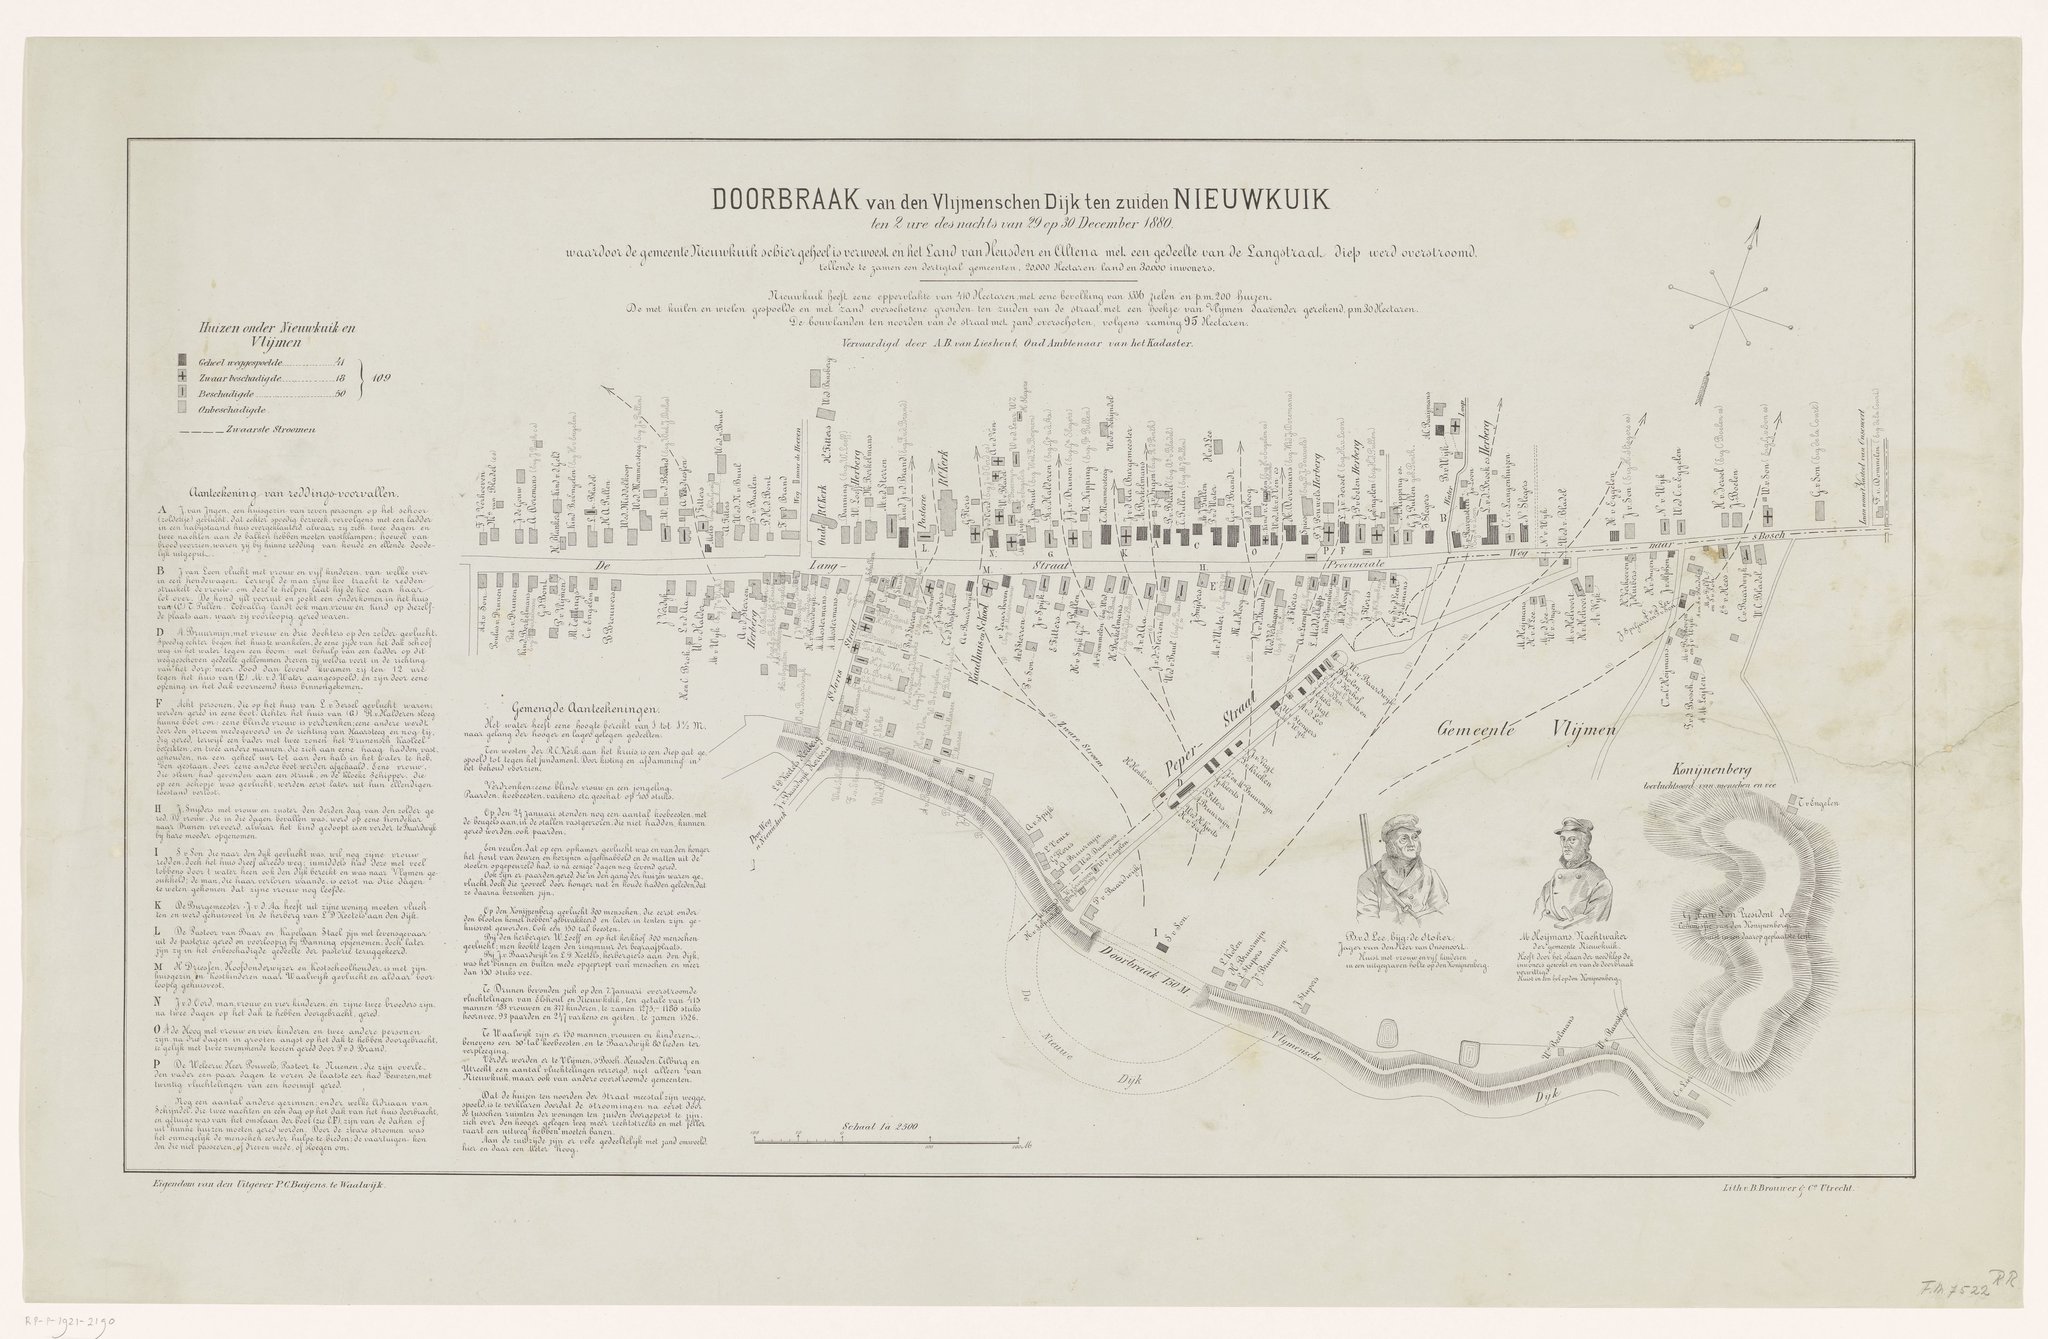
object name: print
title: Doorbraak van den Vlijmensche Dijk ten zuiden Nieuwkuik ten 2 ure des nachts van 29 op 30 December 1880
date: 1880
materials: paper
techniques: lithograph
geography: waalwijk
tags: dike-break, maps of cities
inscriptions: collector's mark: Lugt 2233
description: Kaart van het gebied met de woningen getroffen door het watersnood na het doorbreken van de Vlijmense Dijk ten zuiden Nieuwkuijk in de nacht van 29 op 30 december 1880. Links een lijst van de reddingsgevallen A-P, rechts twee portretten.